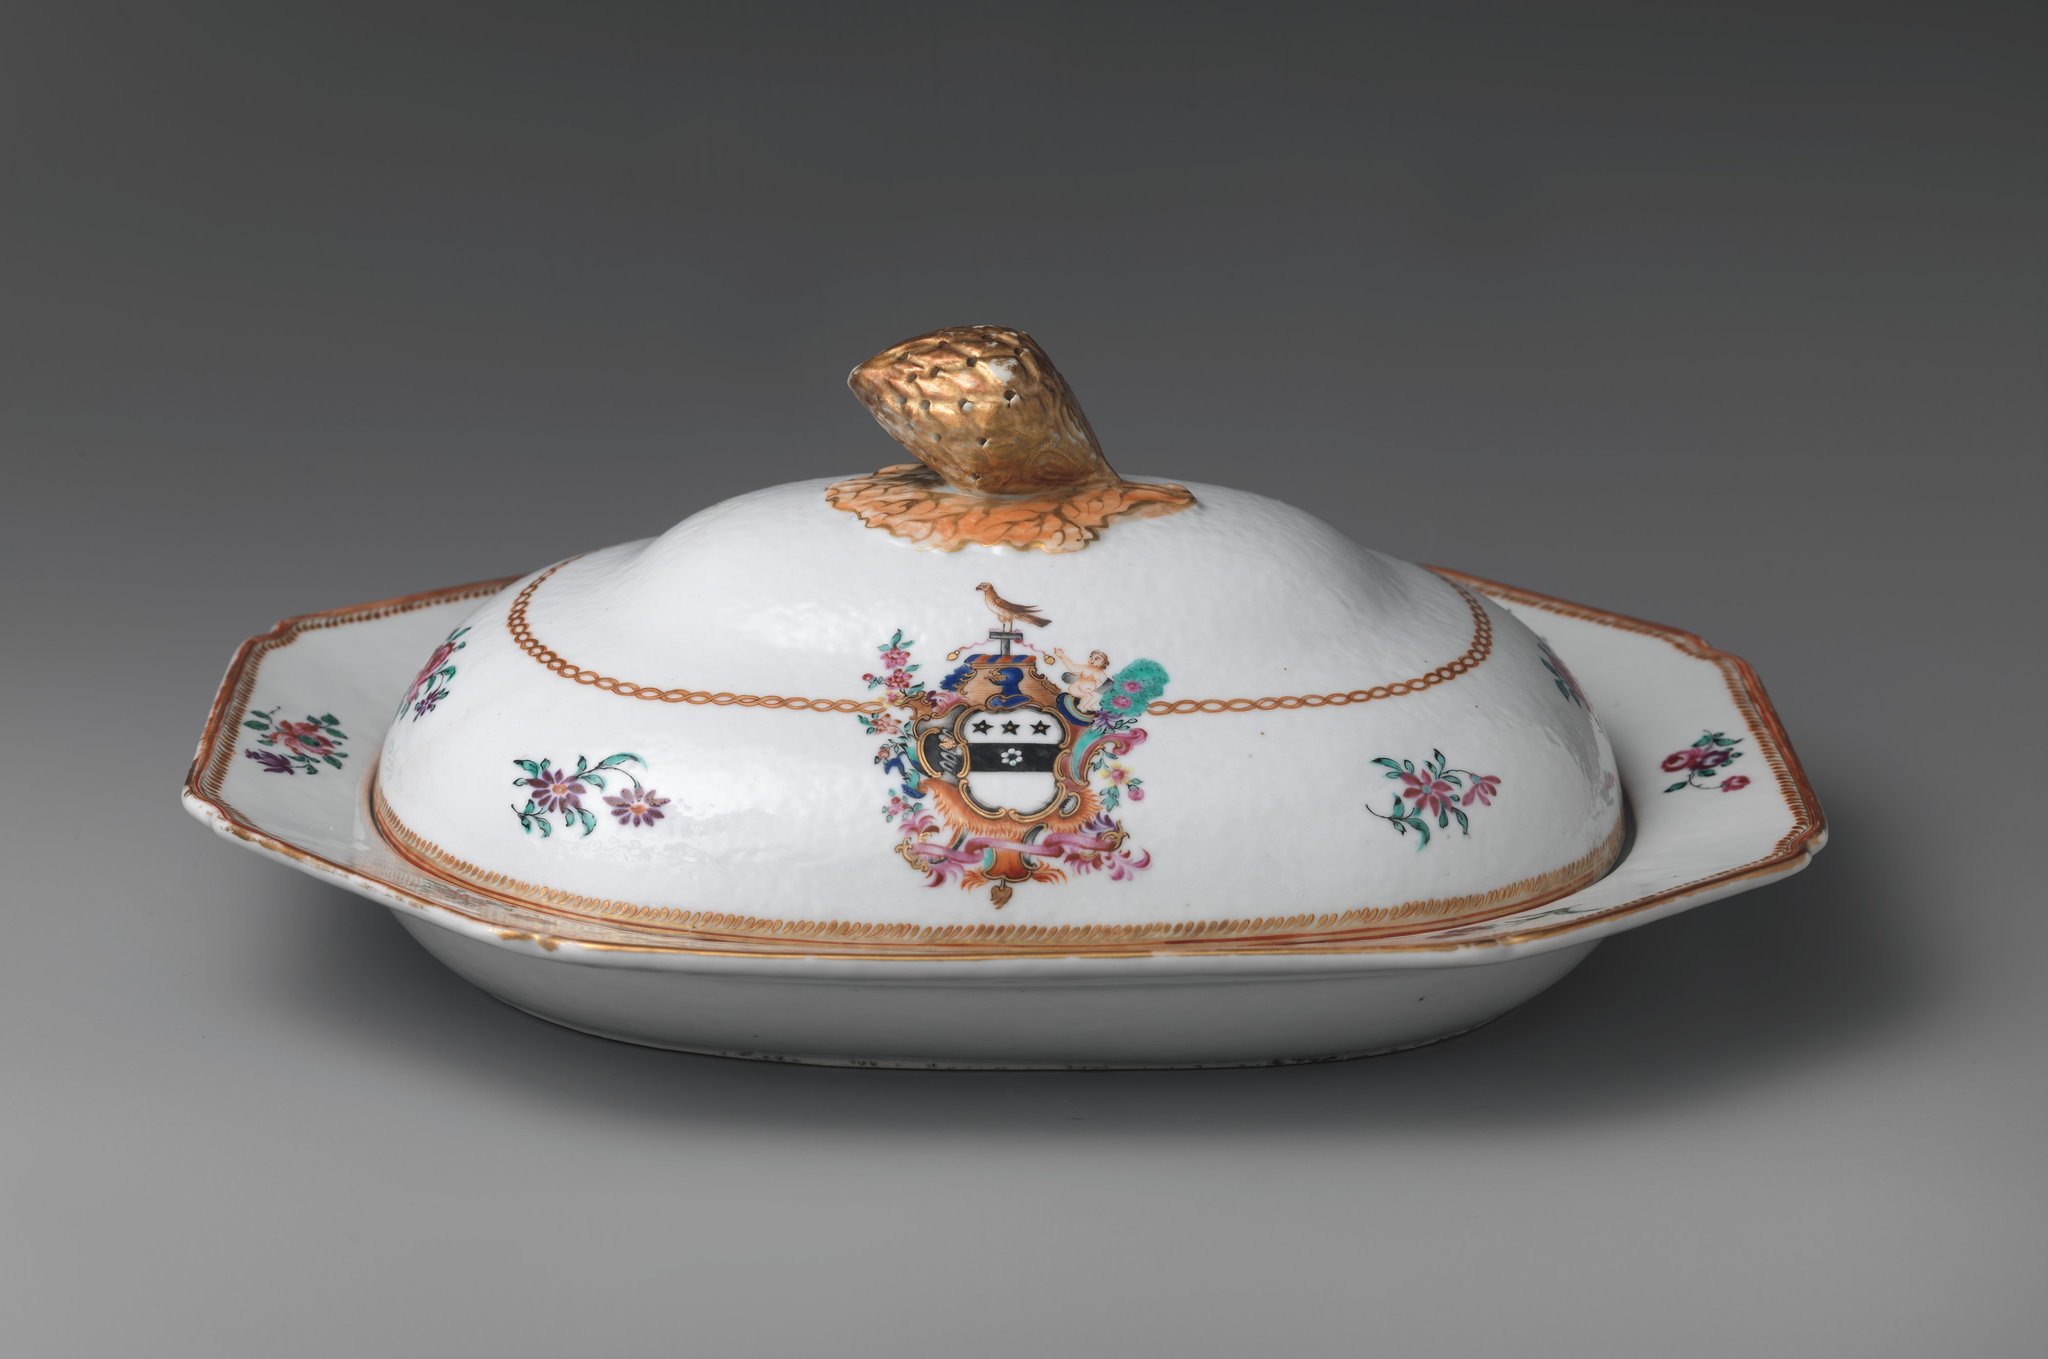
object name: platter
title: Covered Platter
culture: chinese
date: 1785-1790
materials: porcelain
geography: china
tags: birds,flowers,coat of arms